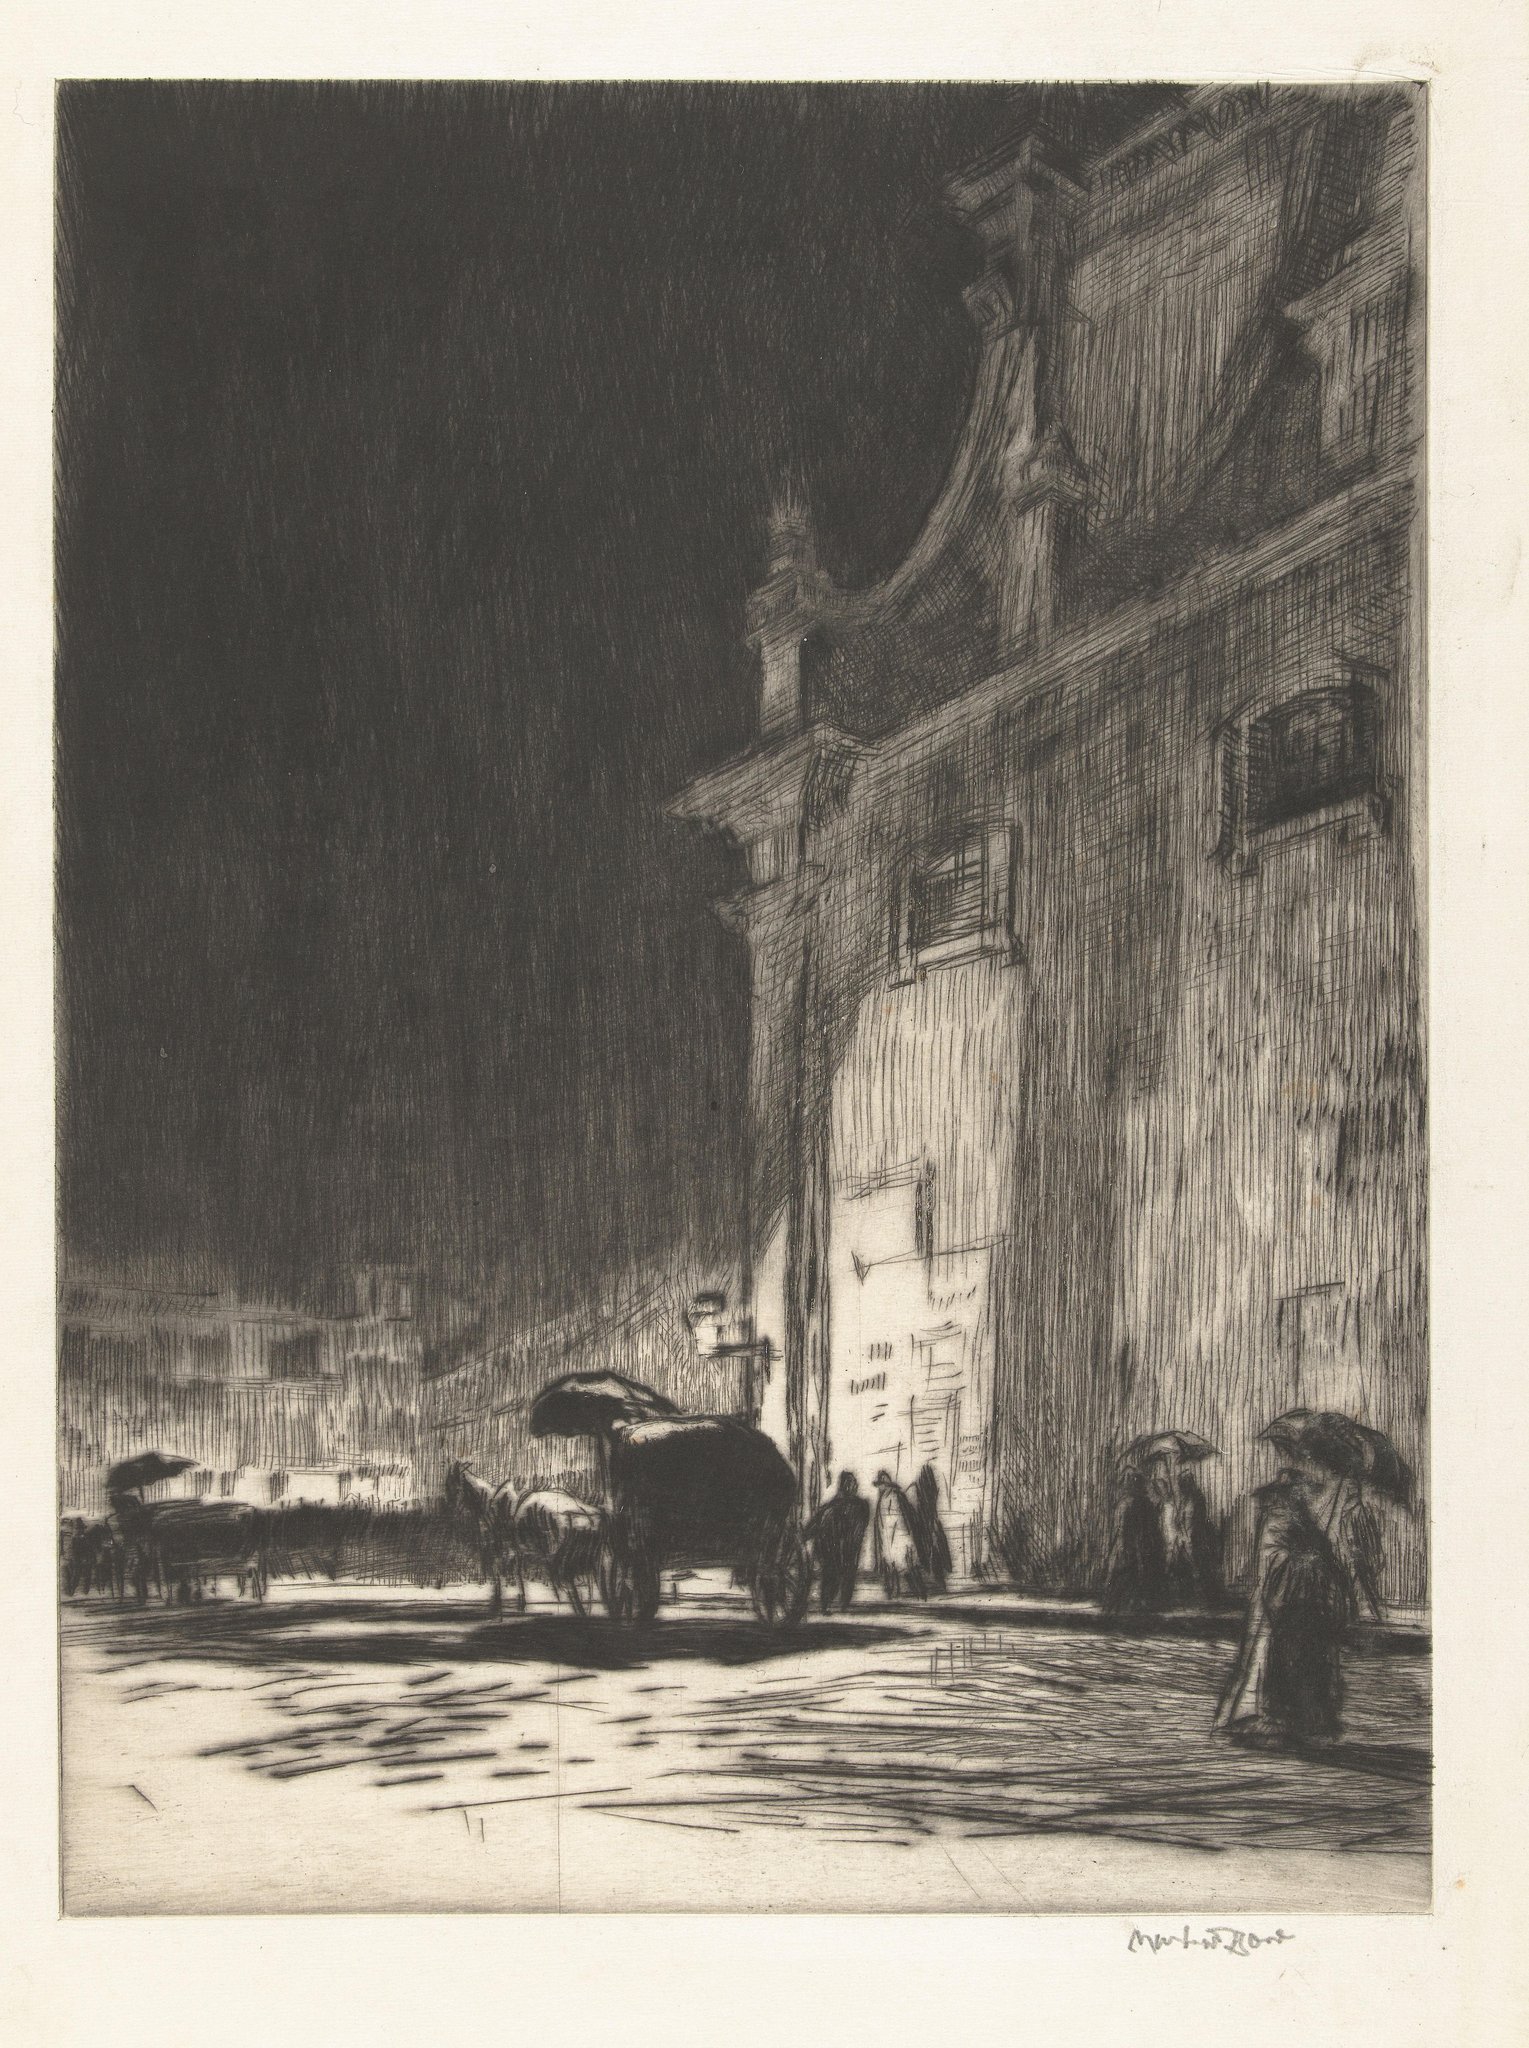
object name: print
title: Rainy Night in Rome.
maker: muirhead bone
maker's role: artist, print maker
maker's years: 1876-1953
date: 1913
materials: paper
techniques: drypoint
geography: england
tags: rain, street, rome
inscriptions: signature: ‘Muirhead Bone’, inscription: ‘very fine impression’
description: Een straat in Rome bij nacht. Op de voorgrond de zijgevel van een kerk waarvoor enkele figuren met paraplu lopen. Een lantaarn schijnt licht op de gevel. Op de straat, die uitloopt op een plein, twee rijtuigen.